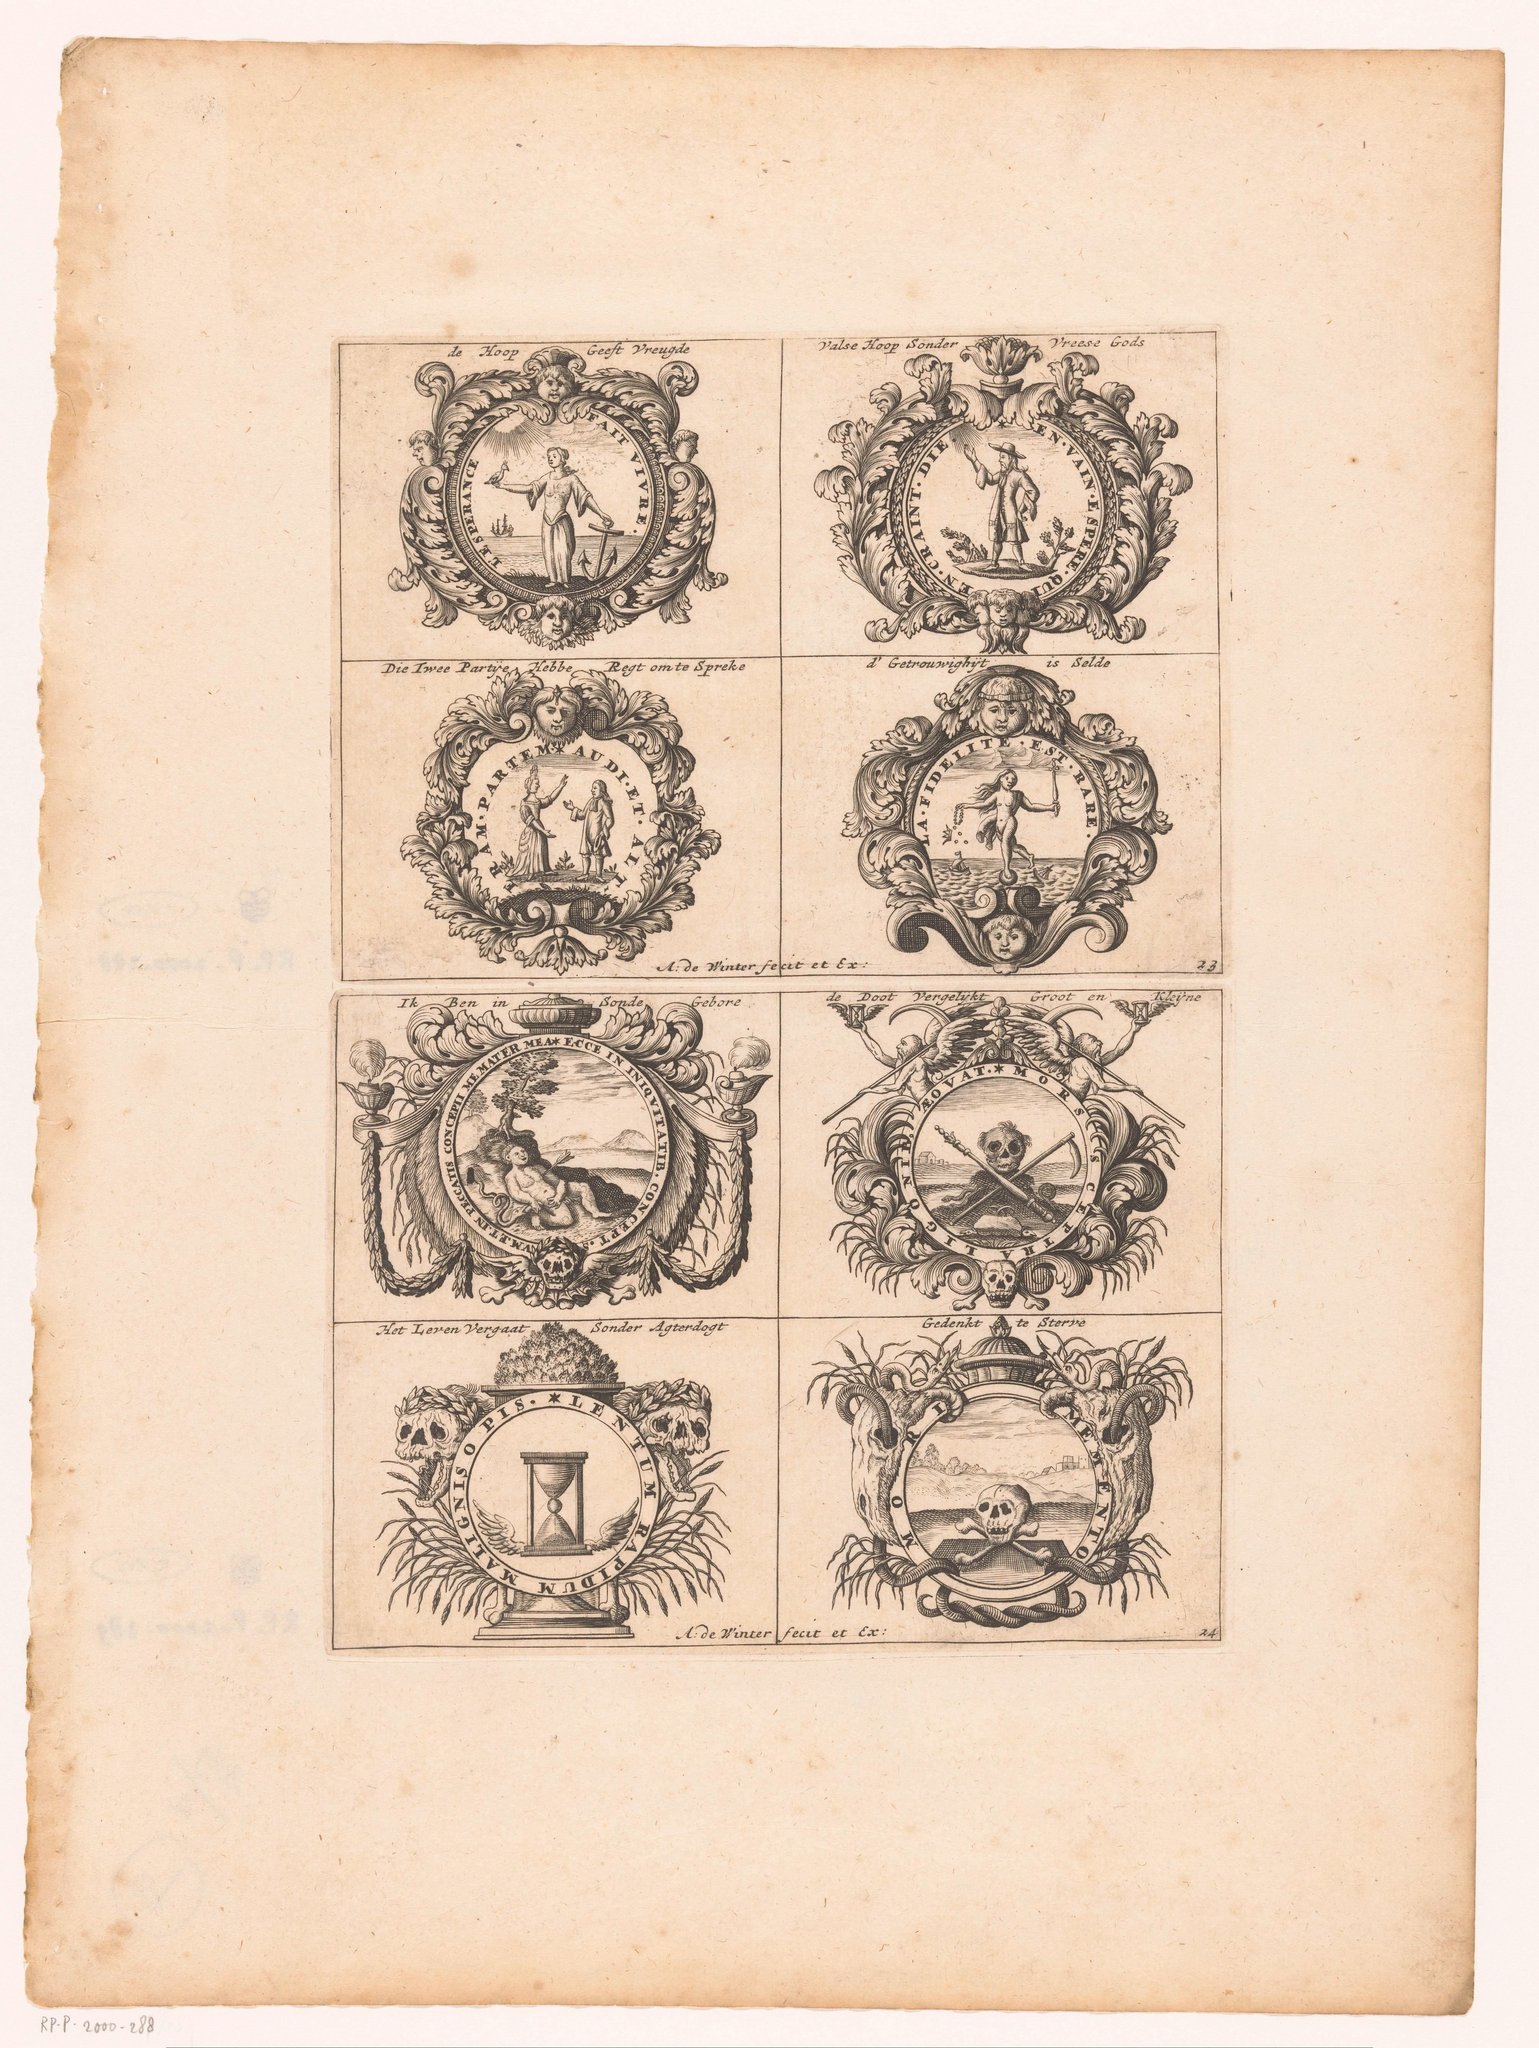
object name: print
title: Verscheijde Nieuwe en Seer Aardige Geinventeertde Compartemente en Sinrijcke Emblemataas of Sinnebeelden seer Dien stigh voor Silversmeeden (...) Twede Deel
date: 1697-1718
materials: paper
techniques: engraving, etching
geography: amsterdam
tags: standing figure, skull as symbol of 'vanitas', abstract ideas and concepts (+ emblematical representation of concept)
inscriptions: collector's mark: Lugt 2228, collector's mark: Lugt 2760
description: Tweemaal vier emblemata met Nederlandse tekst en Latijns motto op een blad. Boven: Emblemata met personificatie van de hoop, een man met een opgeheven hand, een man en vrouw in gesprek en Fortuna met een scepter, kroon en juwelen. Onder: Emblemata met Amor geraakt door een pijl, een schedel met scepter en zeis, een gevleugelde zandloper en een schedel.